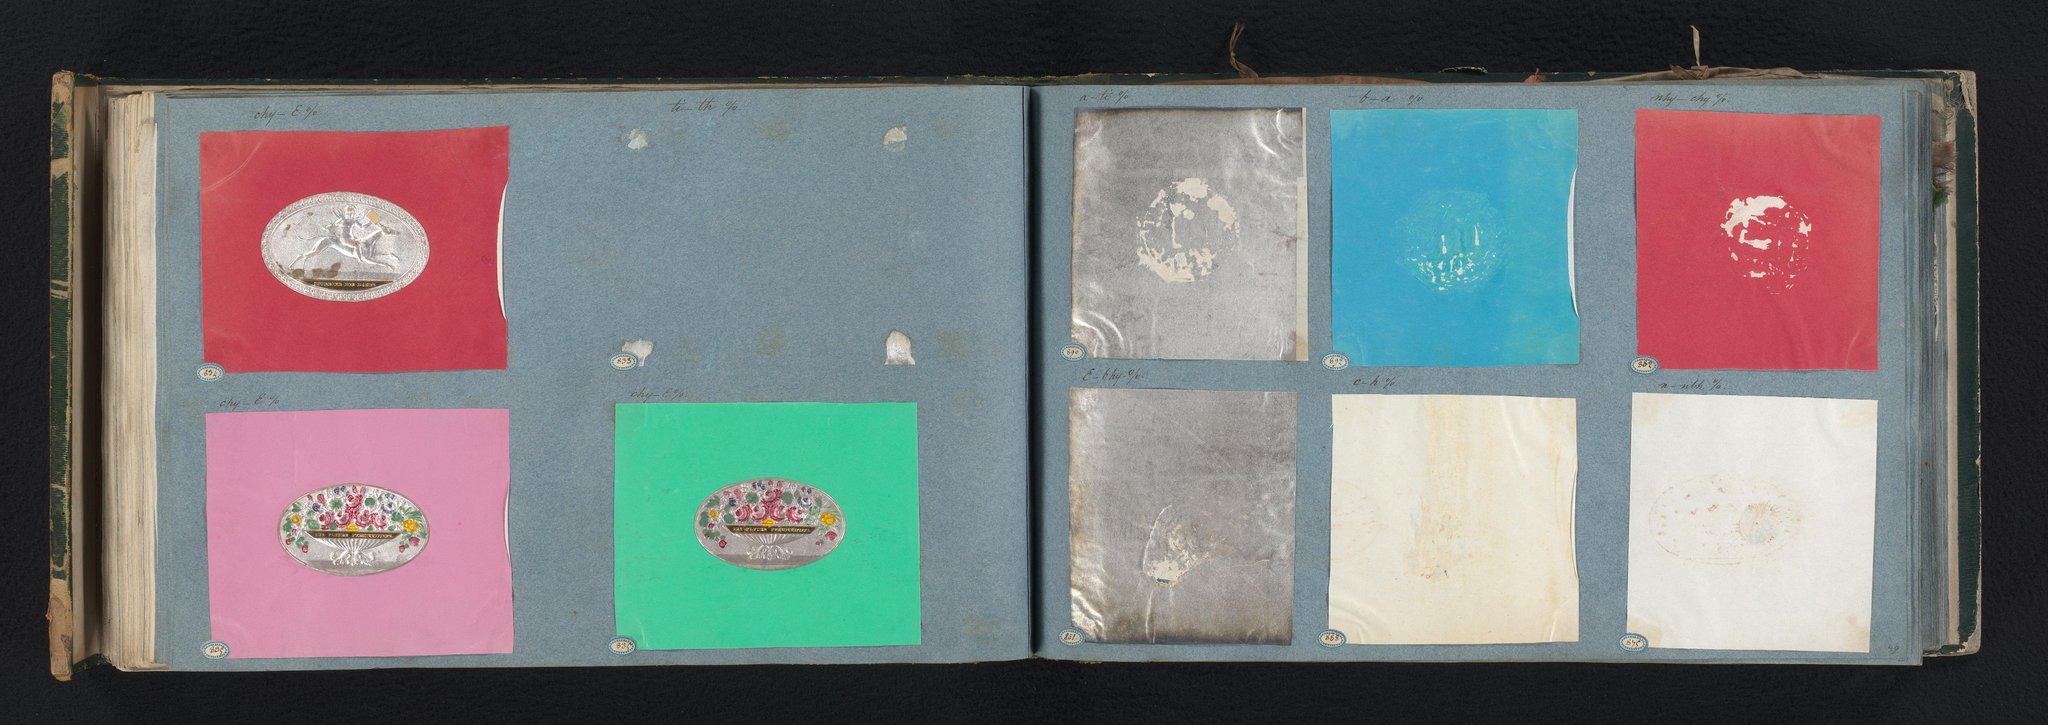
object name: album leaf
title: Twee bladzijden met stalen van zilverkleurig metaalpapier en gekleurd papier met verschillende gekleurde vignetten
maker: Anonymous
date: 1830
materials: ink, paper, silver leaf, watercolor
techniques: manufacturing, hand coloring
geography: france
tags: cut flowers; nosegay, bunch of flowers, ornaments ~ art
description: Twee bladzijden met 9 opgeplakte stalen van gekleurd papier en effen zilverkleurig metaalpapier. Met twee handgekleurde vignetten met bloemstukken en een zilverkleurig vignet met een putto op een hond. Op de rechterbladzijde ontbreken de vignetten. Alle stalen voorzien van etiketten met nummers (834-875) en handgeschreven codes. Onderdeel van het stalenboek geschonken door de dames Van Rijn, vermoedelijk van een Franse papierfabrikant van luxe papieren, of diens vertegenwoordiger in Nederland, ca. 1830.